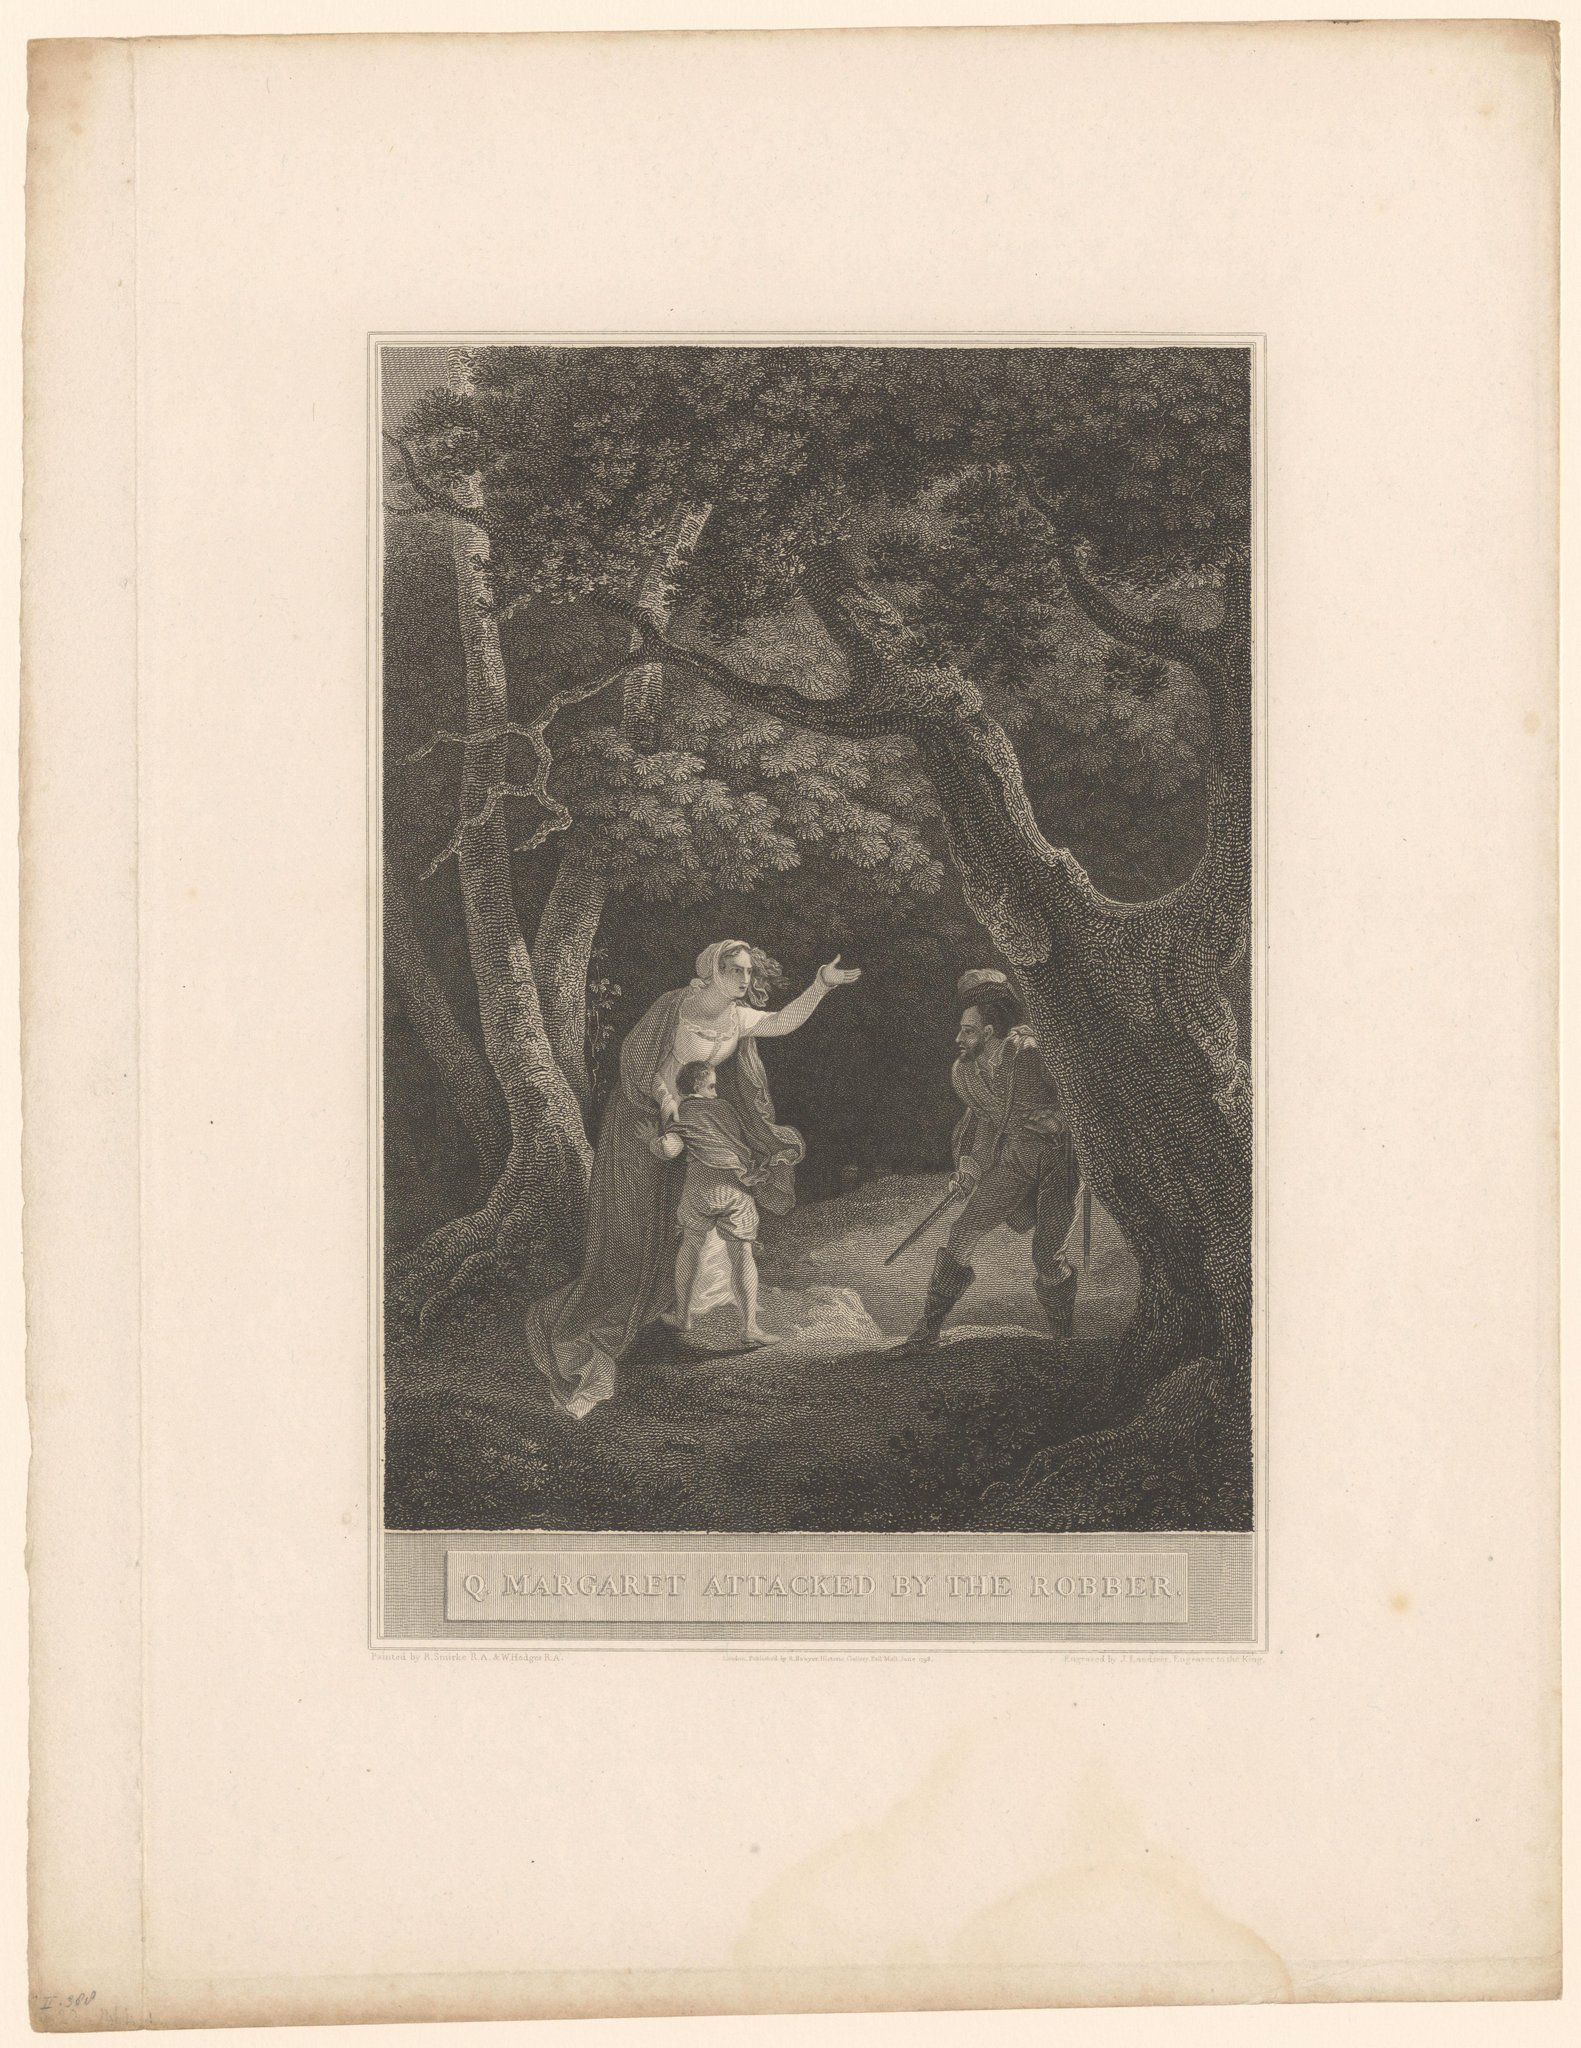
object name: print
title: Q. Margaret attacked by the Robber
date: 1798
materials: paper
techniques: engraving, etching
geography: london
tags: historical persons, surprise attack (from ambush)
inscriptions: collector's mark: Lugt 2228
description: Deze prent is gebruikt in: The History of England. Londen: Robert Bowyer, 1798. Deze editie is gebaseerd op David Hume's uitgave van 'The History of England', waarvan het eerste deel verscheen in 1754 en het laatste in 1762.